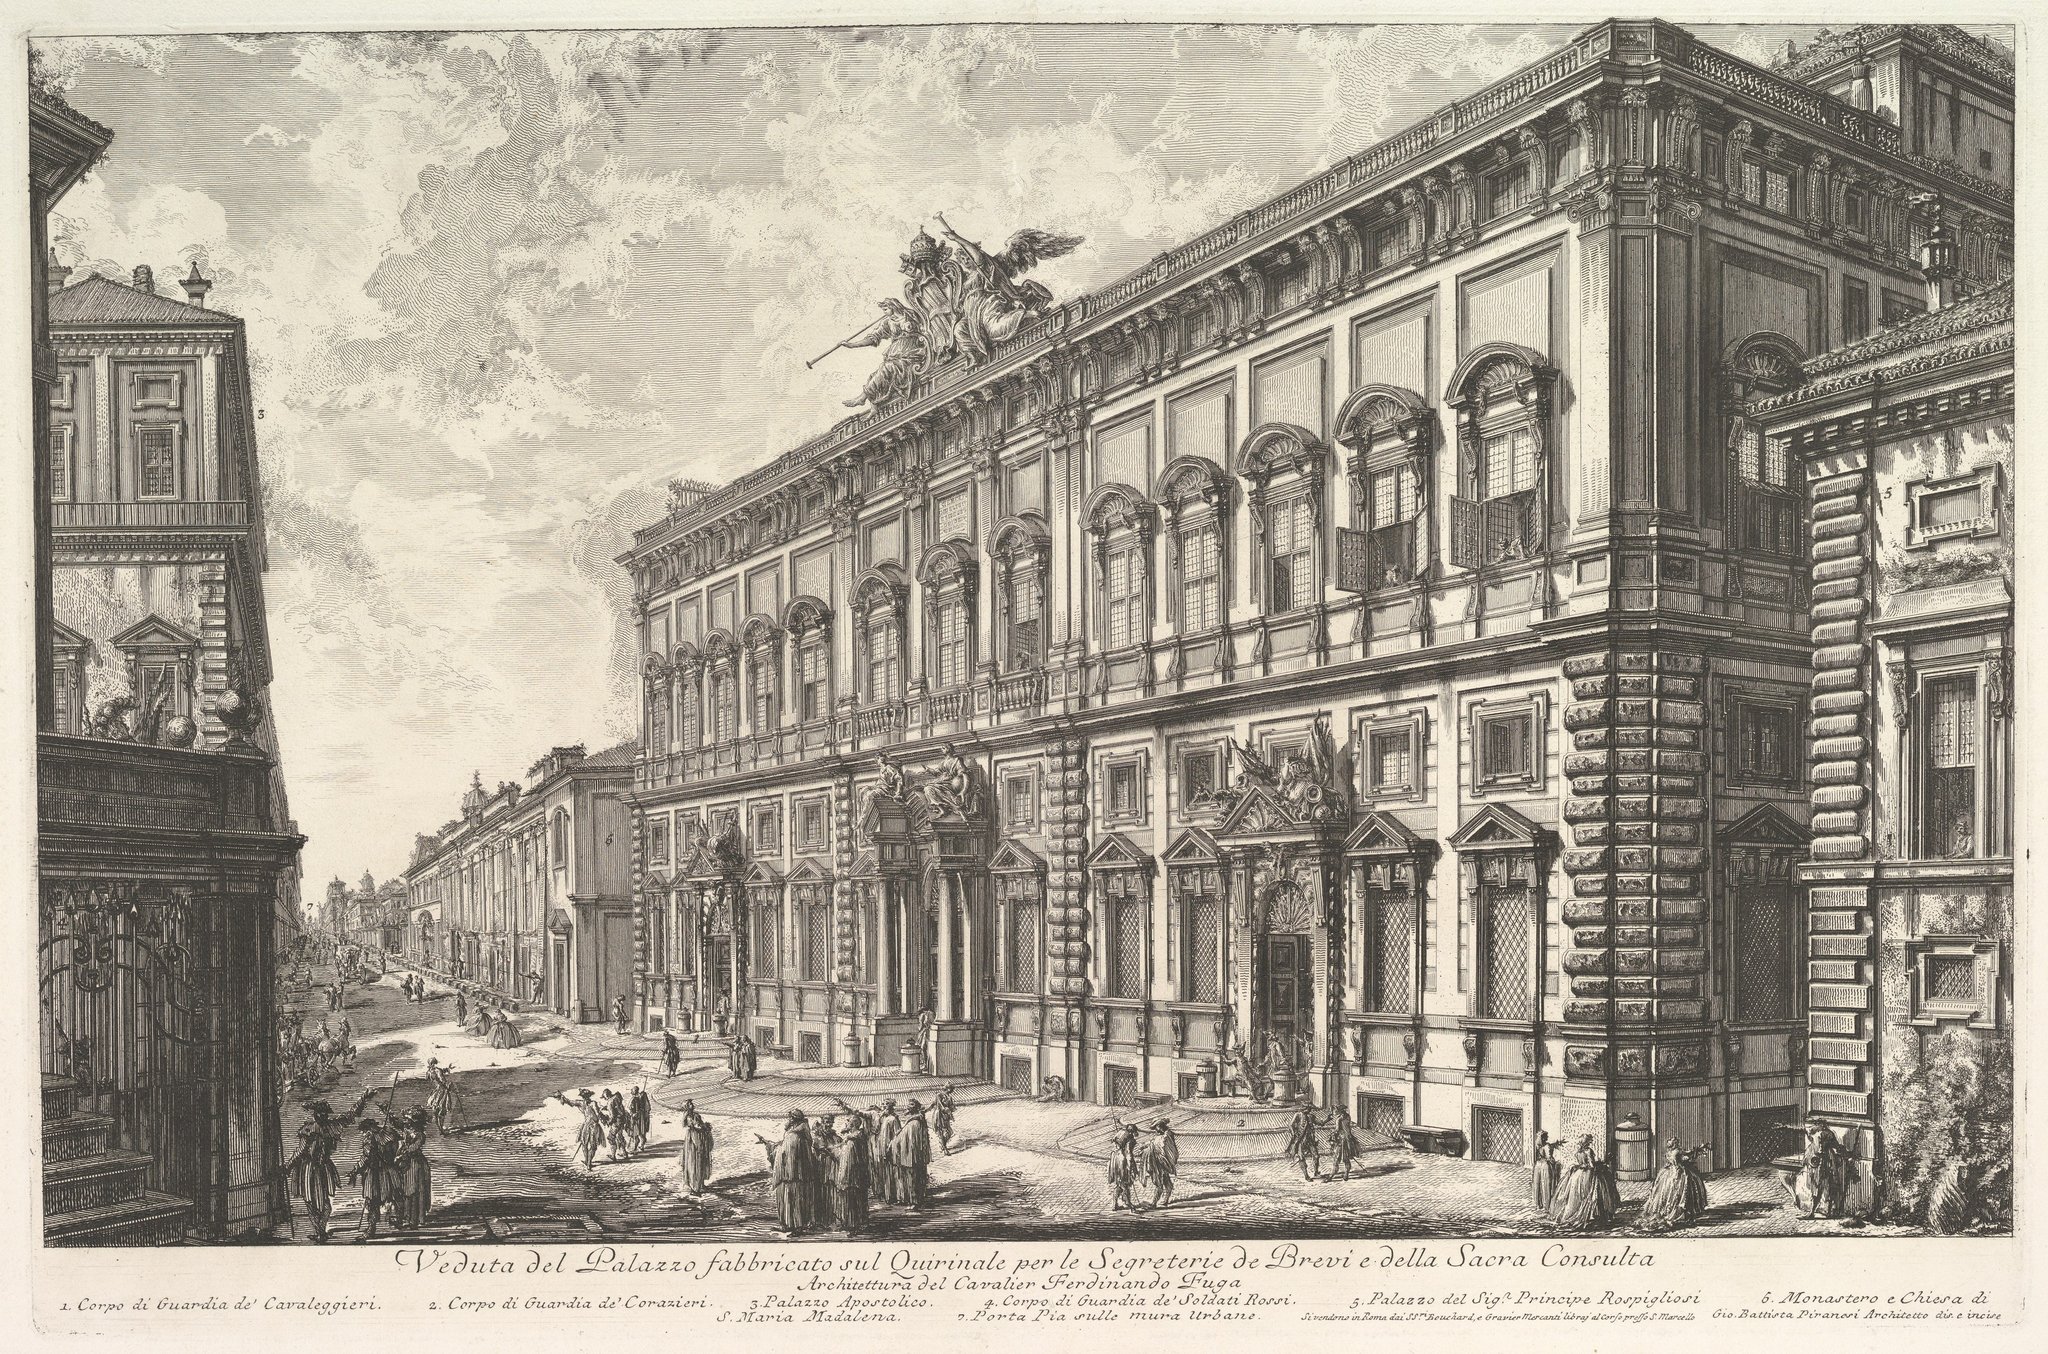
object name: print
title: View of the Palazzo della Consulta on the Quirinal housing the Papal Secreteriat, from Vedute di Roma (Roman Views)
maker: giovanni battista piranesi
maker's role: artist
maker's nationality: italian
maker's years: 1720-1778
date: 1760-1778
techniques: etching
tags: palaces,rome